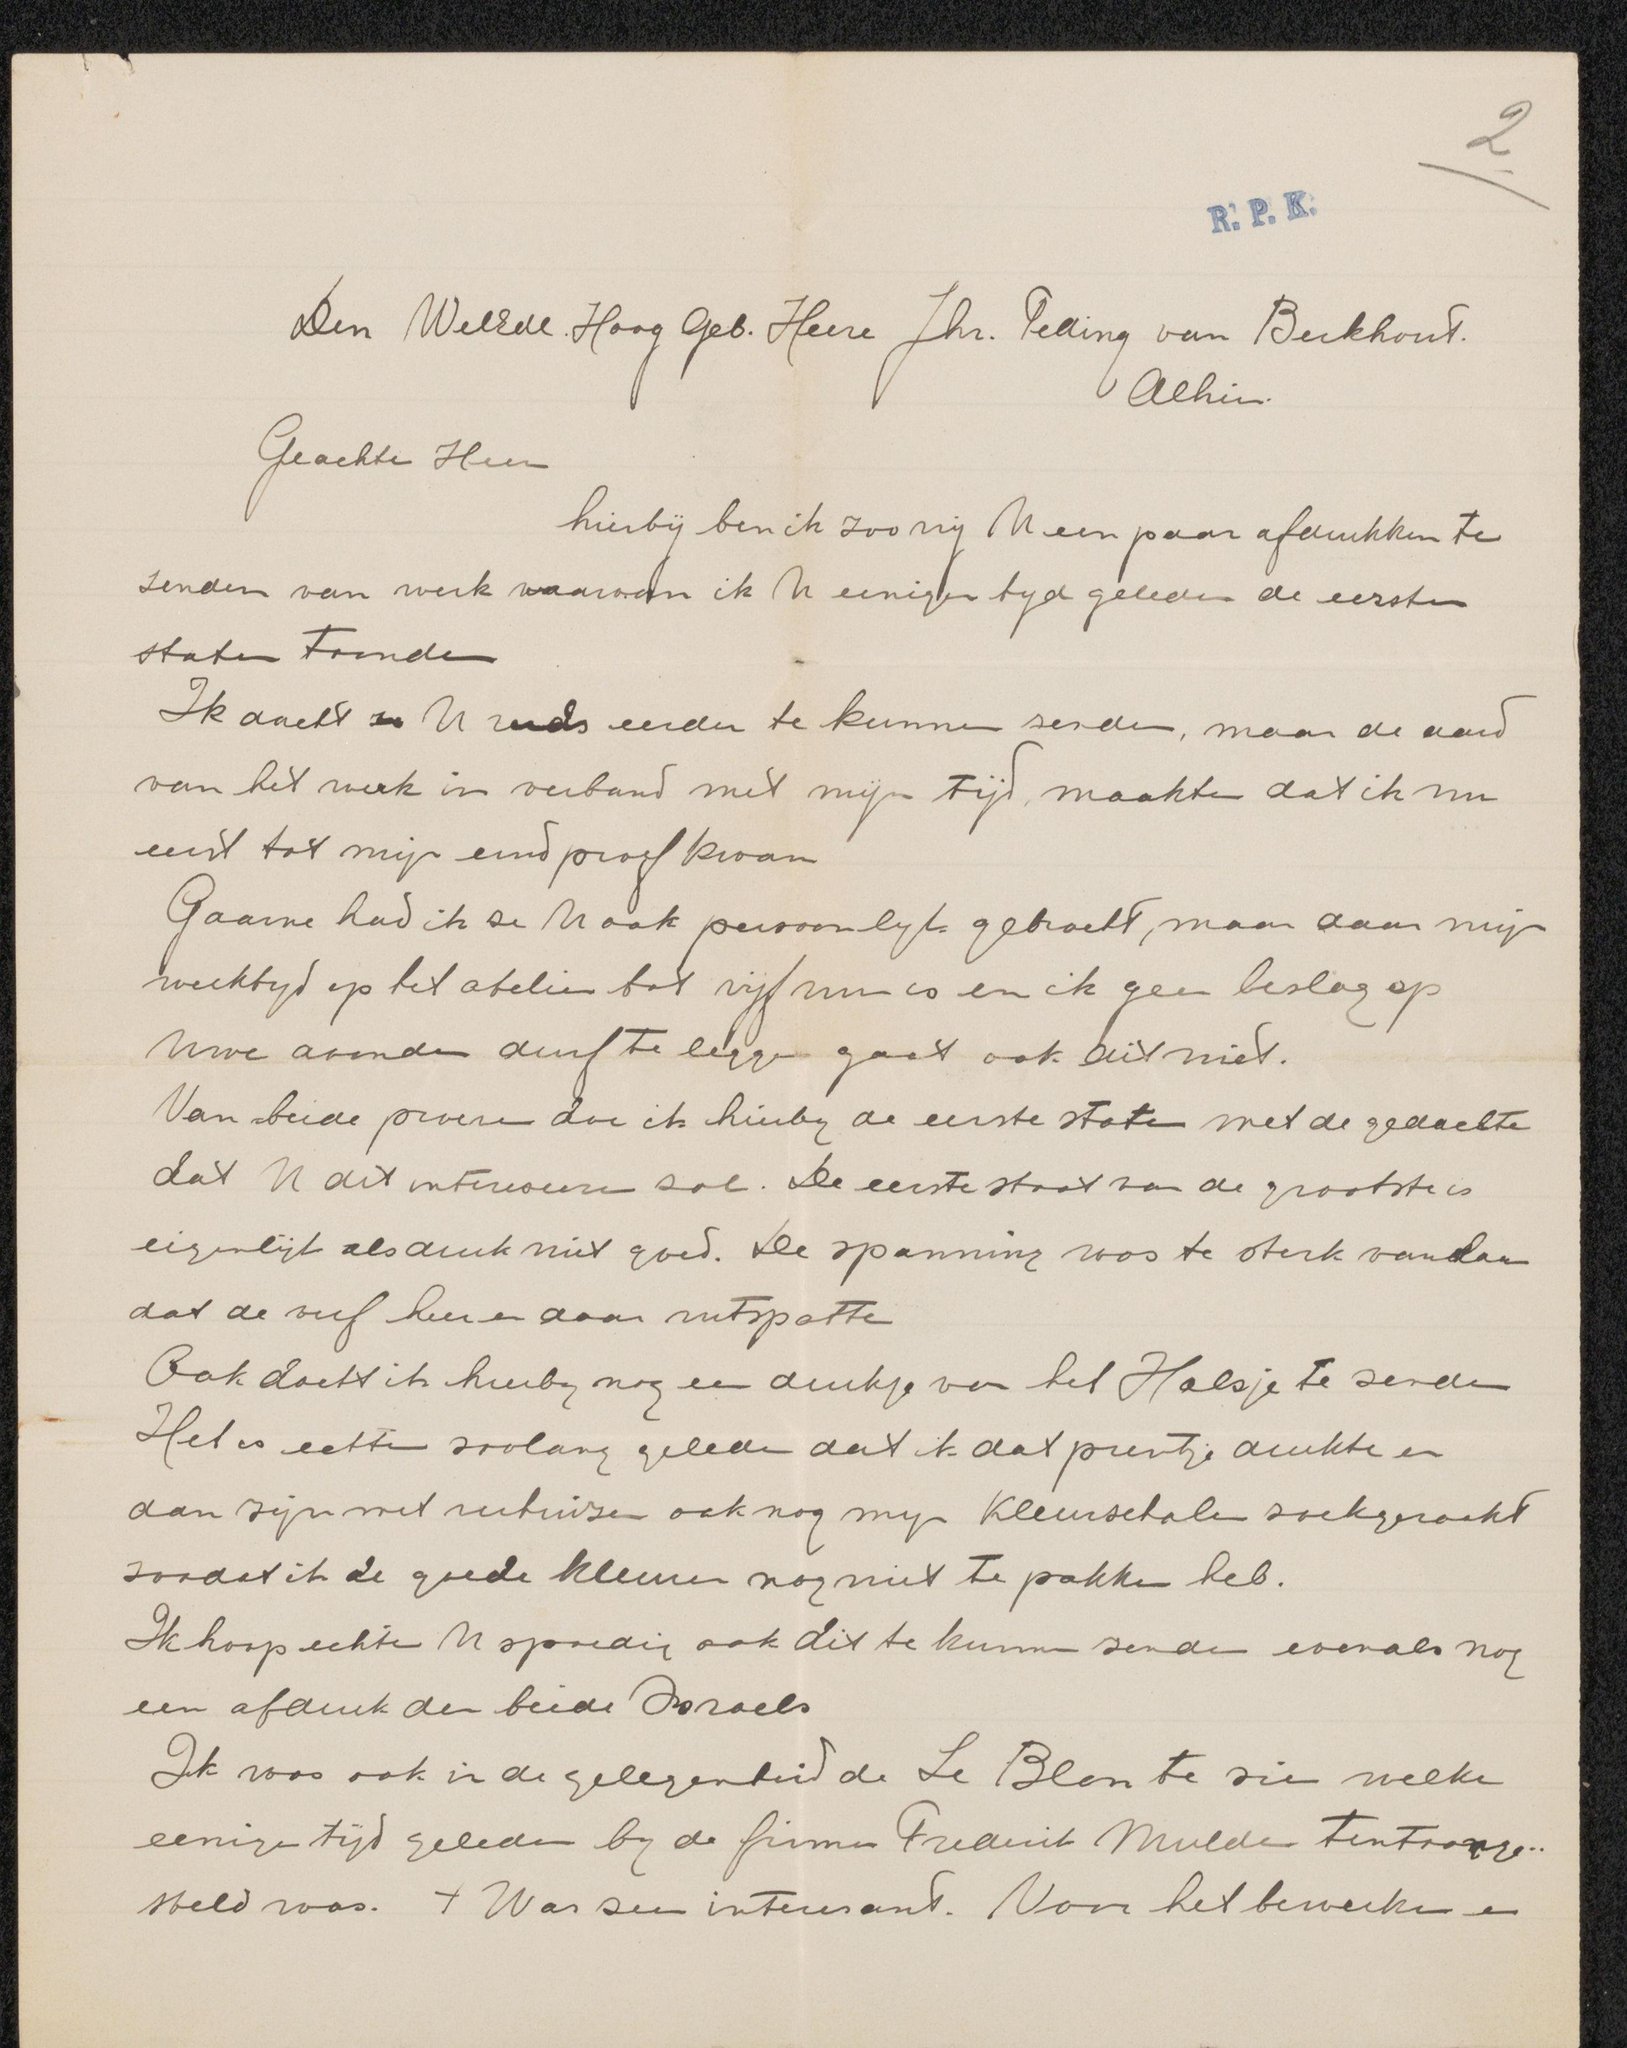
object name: letter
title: Brief aan jonkheer Hendrik Teding van Berkhout (1879-1969)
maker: frans everbag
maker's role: draughtsman, print maker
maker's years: 1877-1947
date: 1913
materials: ink, paper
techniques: pen, writing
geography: amsterdam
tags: michiel le blon, haarlem, amsterdam, jonkheer hendrik teding van berkhout (1879-1969), the graphic arts, workshop, studio of the artist (in general), exhibition ~ art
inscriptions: collector's mark: Lugt 2233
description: Vomt samen met RP-D-EVERBAG.F-3 een doorlopende brief.